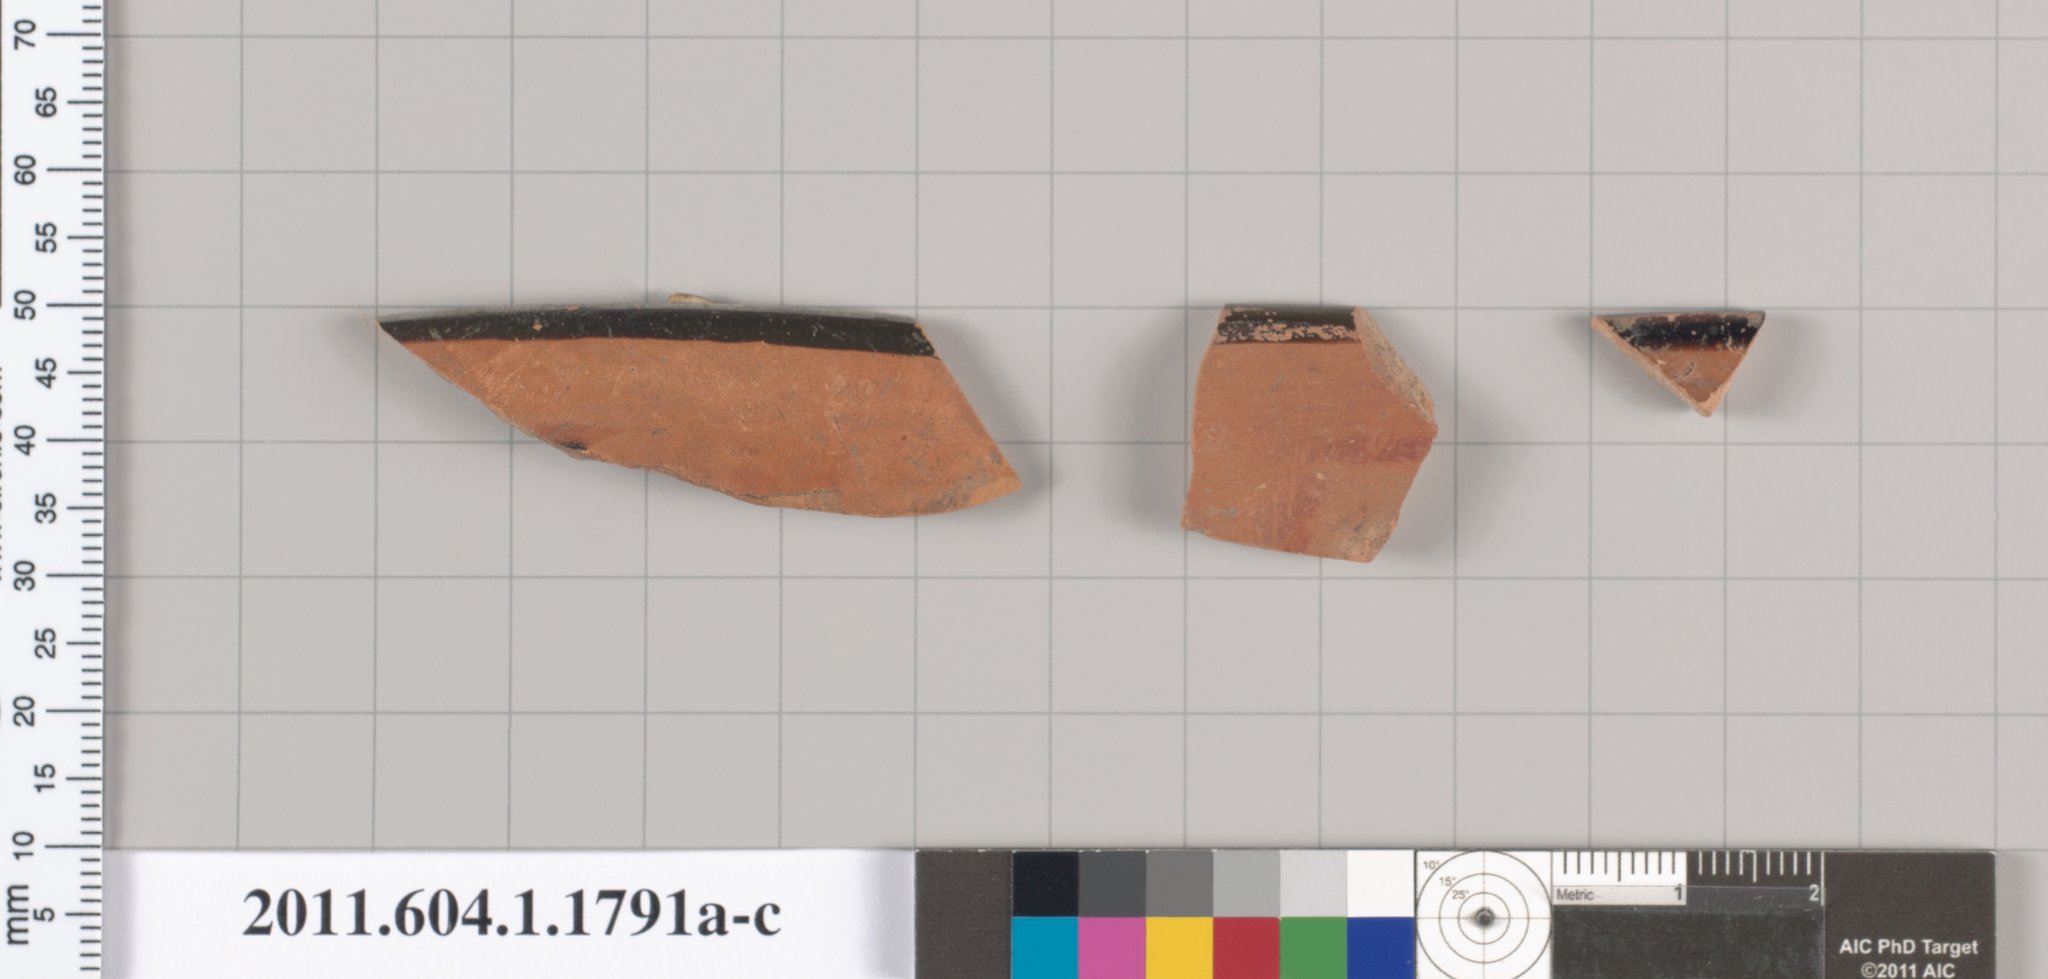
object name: kylix fragment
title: Terracotta rim fragments of kylikes(drinking cups)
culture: greek, attic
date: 500-401 BCE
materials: terracotta